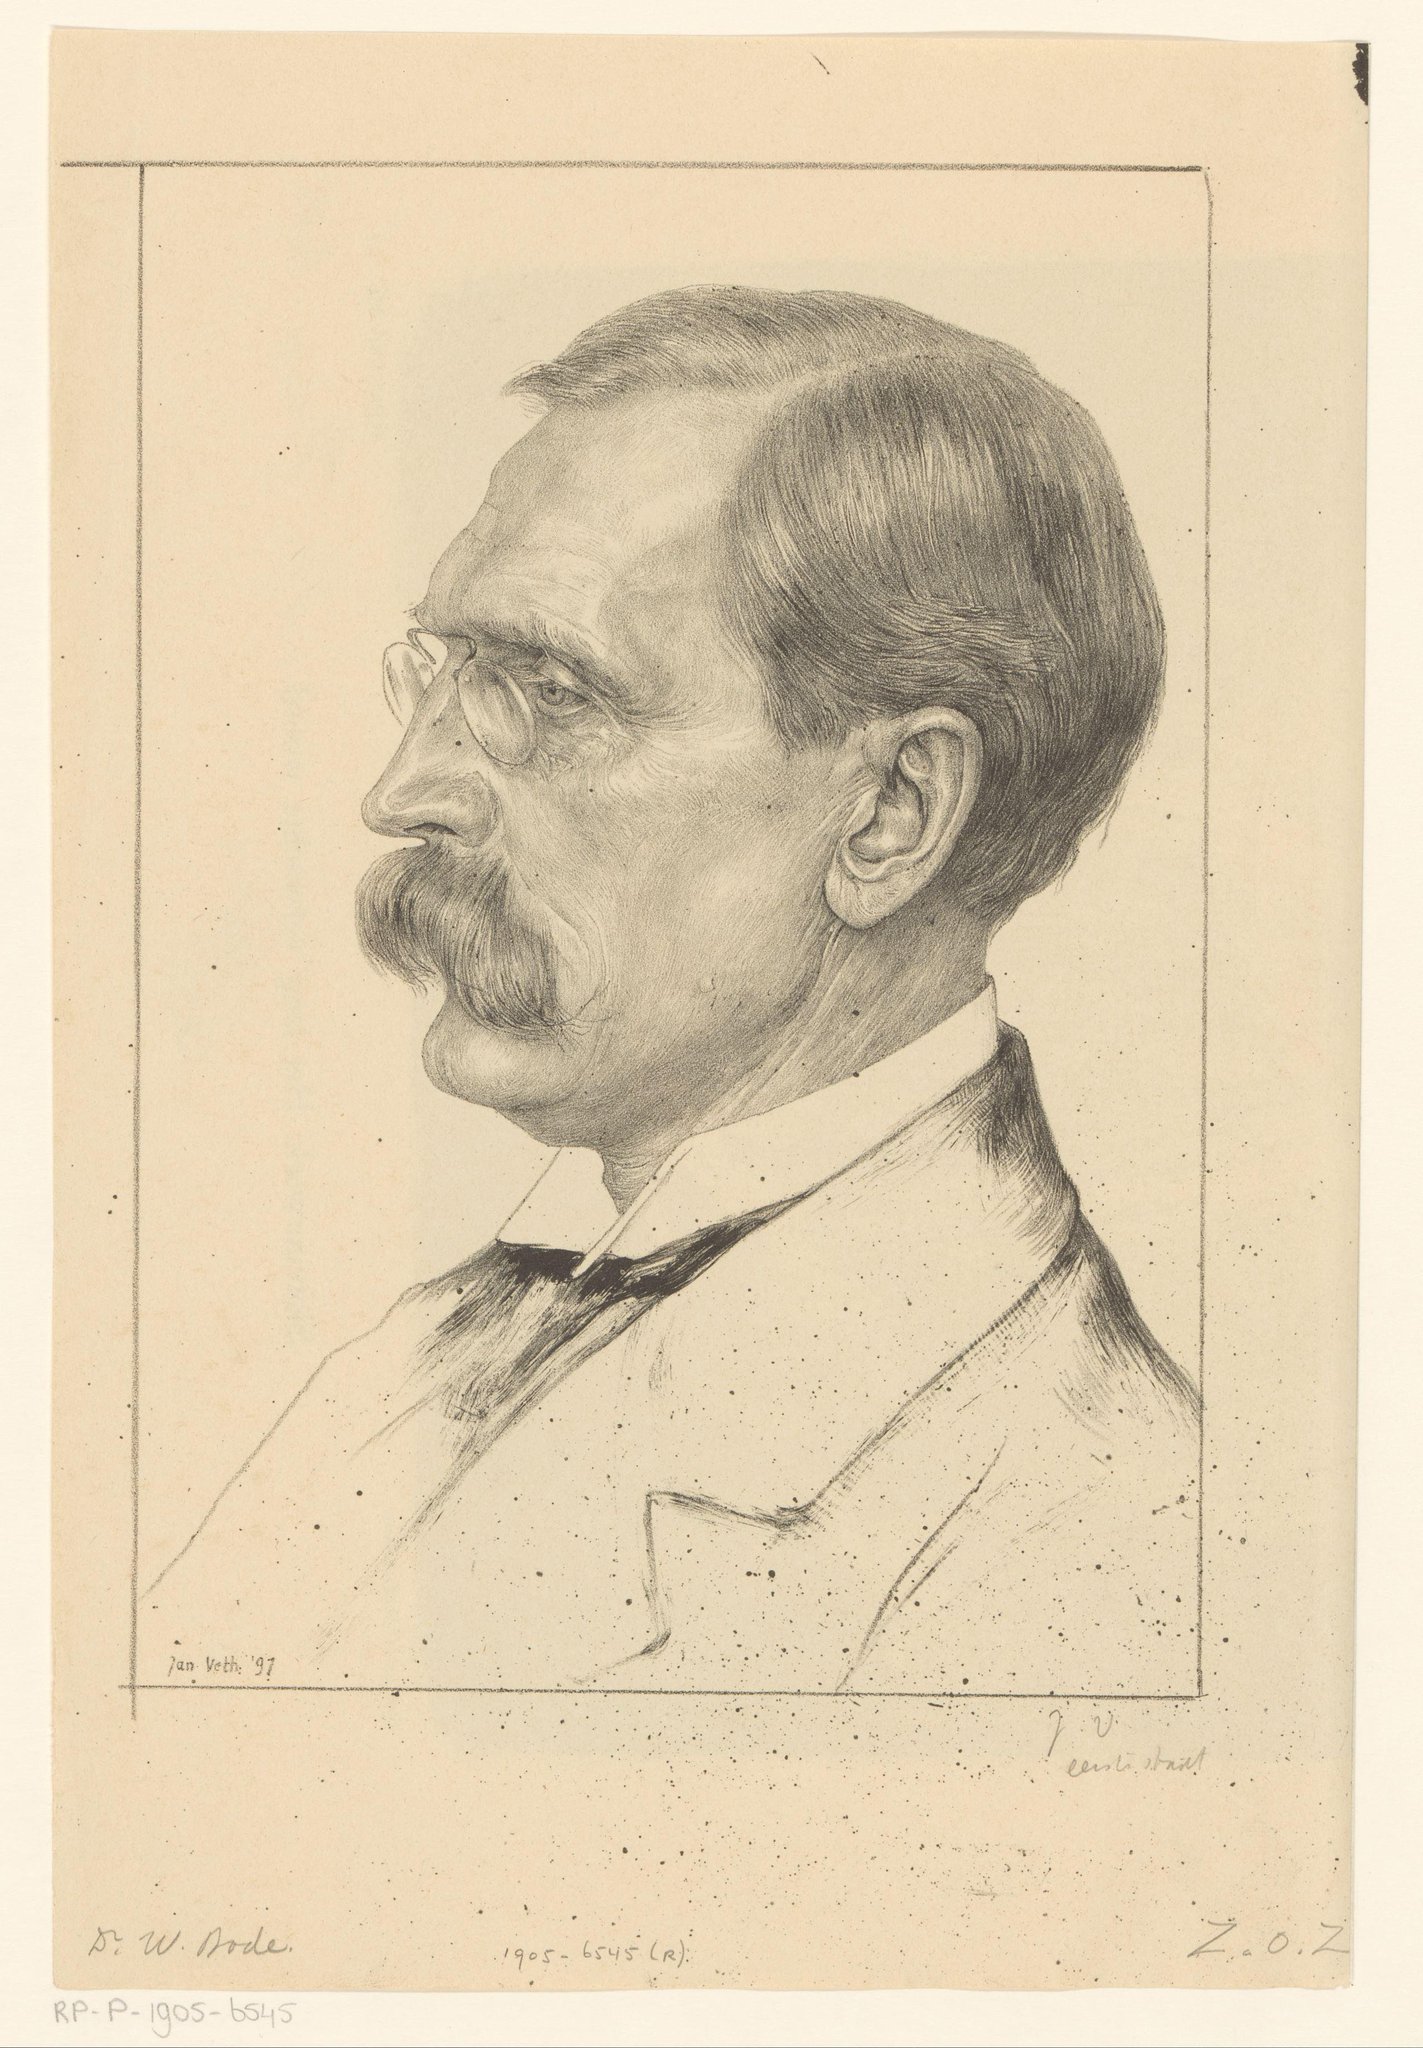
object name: print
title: Portretten van De Kroniek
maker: jan veth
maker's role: designer, draughtsman, painter, print maker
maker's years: 1864-1925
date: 1897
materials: paper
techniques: lithograph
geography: netherlands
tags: berlin, wilhelm von bode, historical persons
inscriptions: inscription: ‘J.V. / eerste staat’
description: Dit portret werd uitgegeven als bijvoegsel bij De Kroniek op 23 oktober 1898.